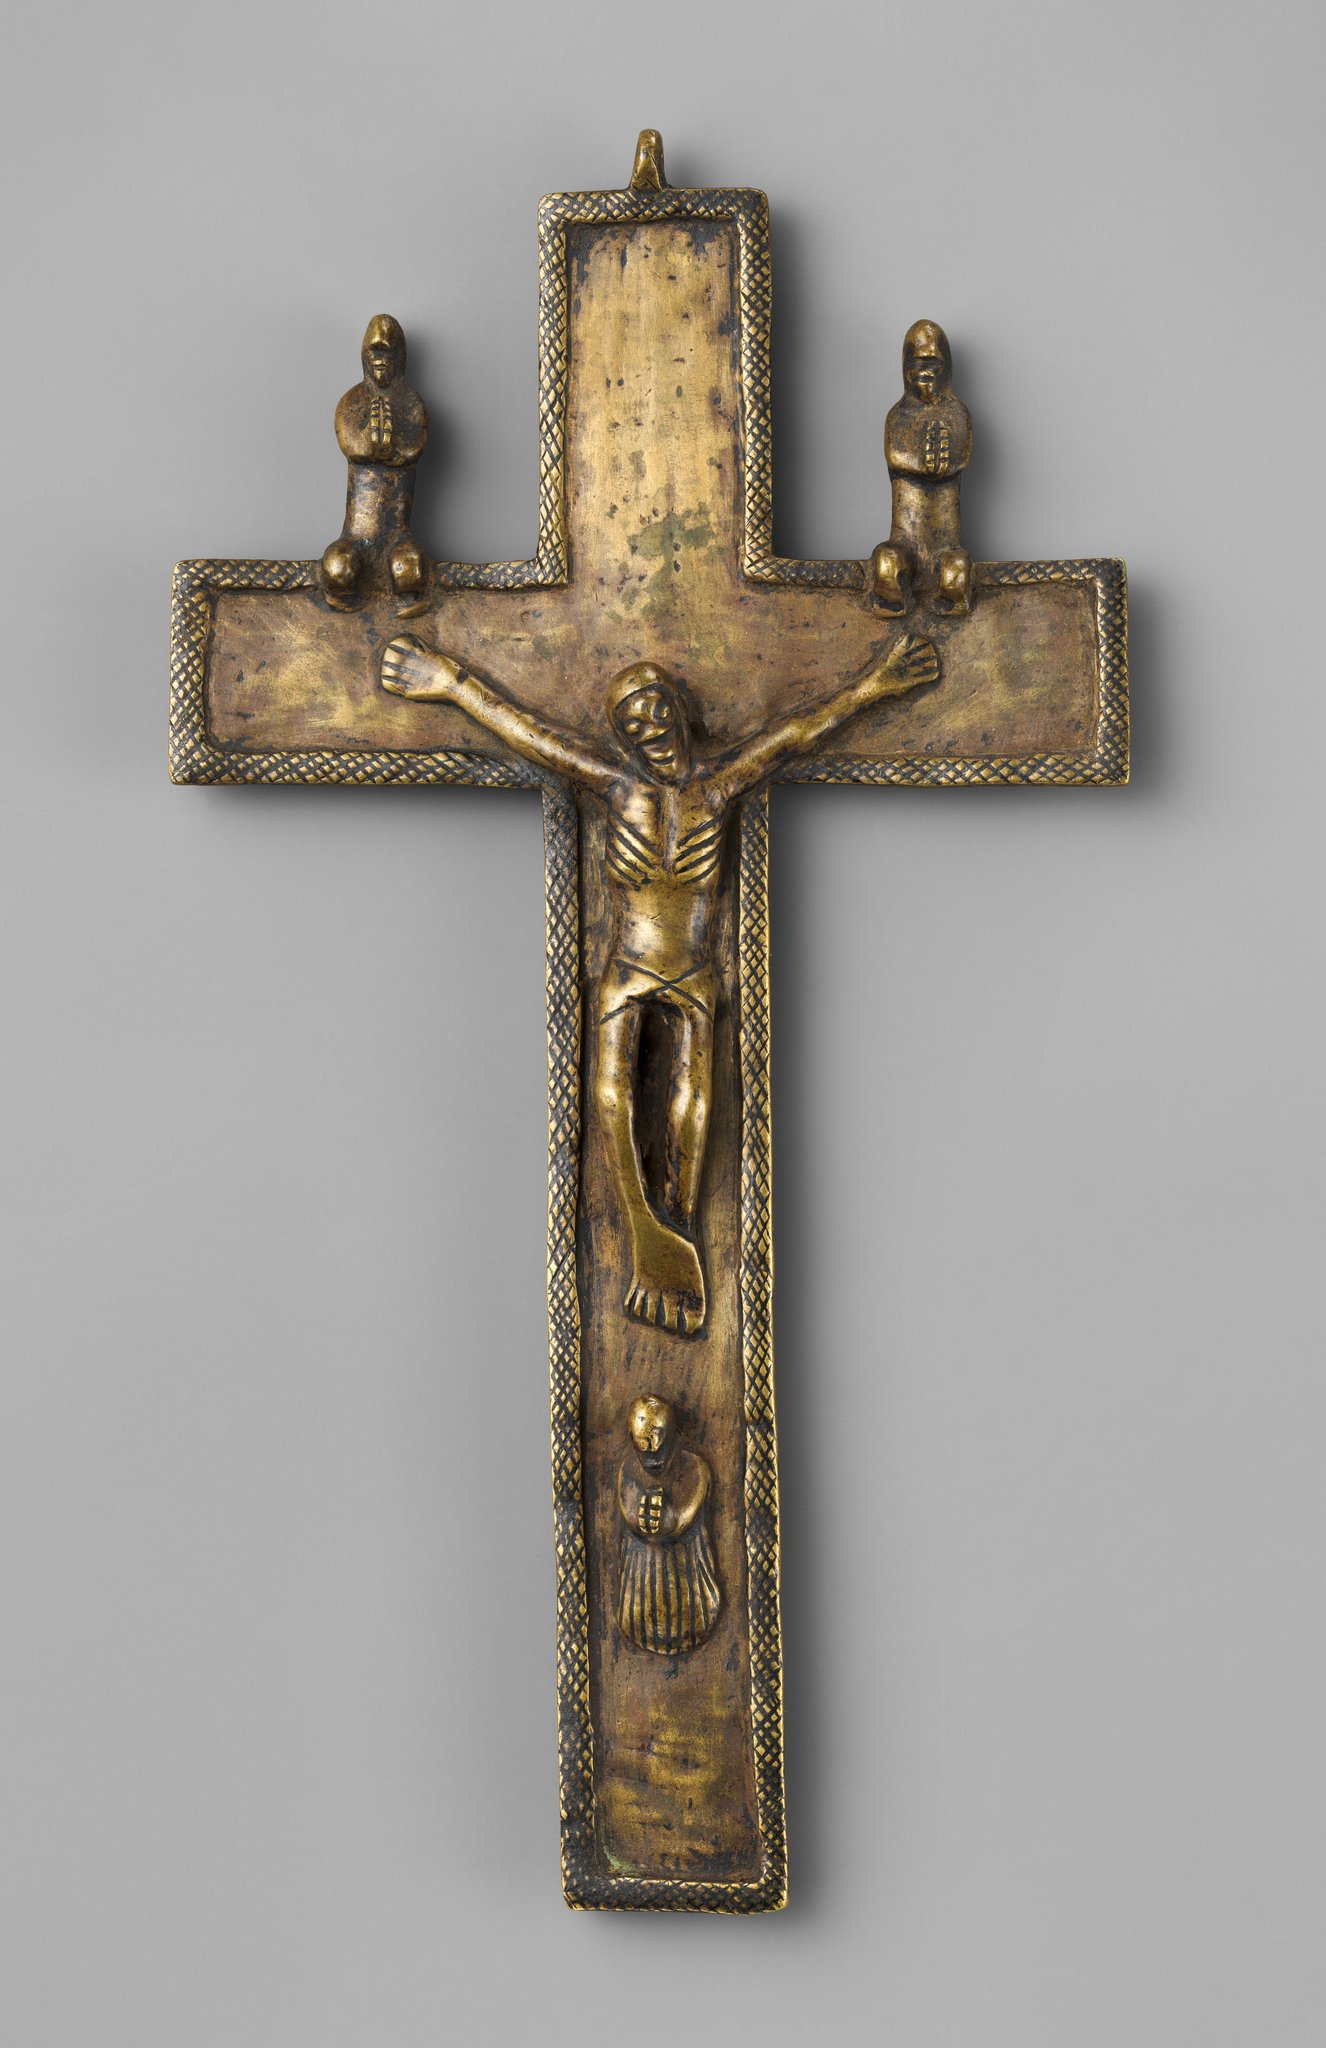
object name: crucifix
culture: kongo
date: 1701-1900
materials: brass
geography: angola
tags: christ,cross,crucifixion